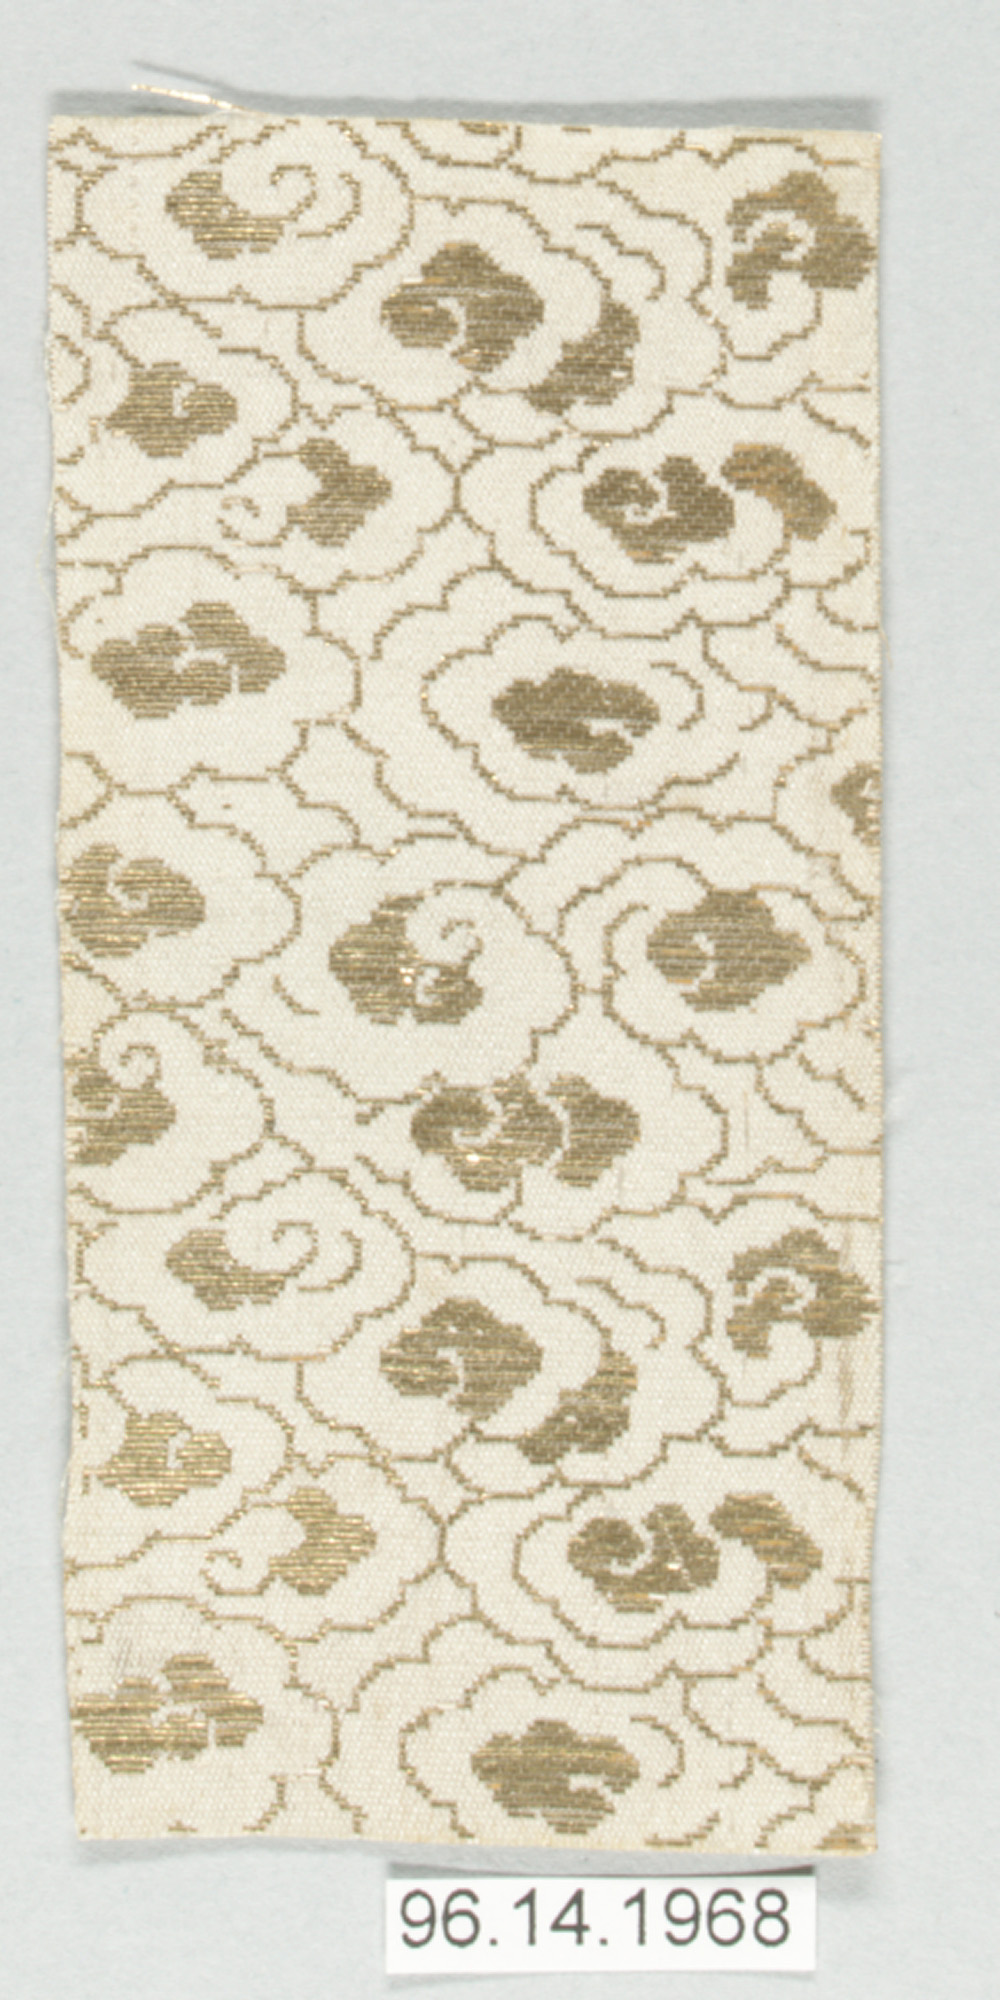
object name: piece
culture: japanese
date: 1701-1900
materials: silk